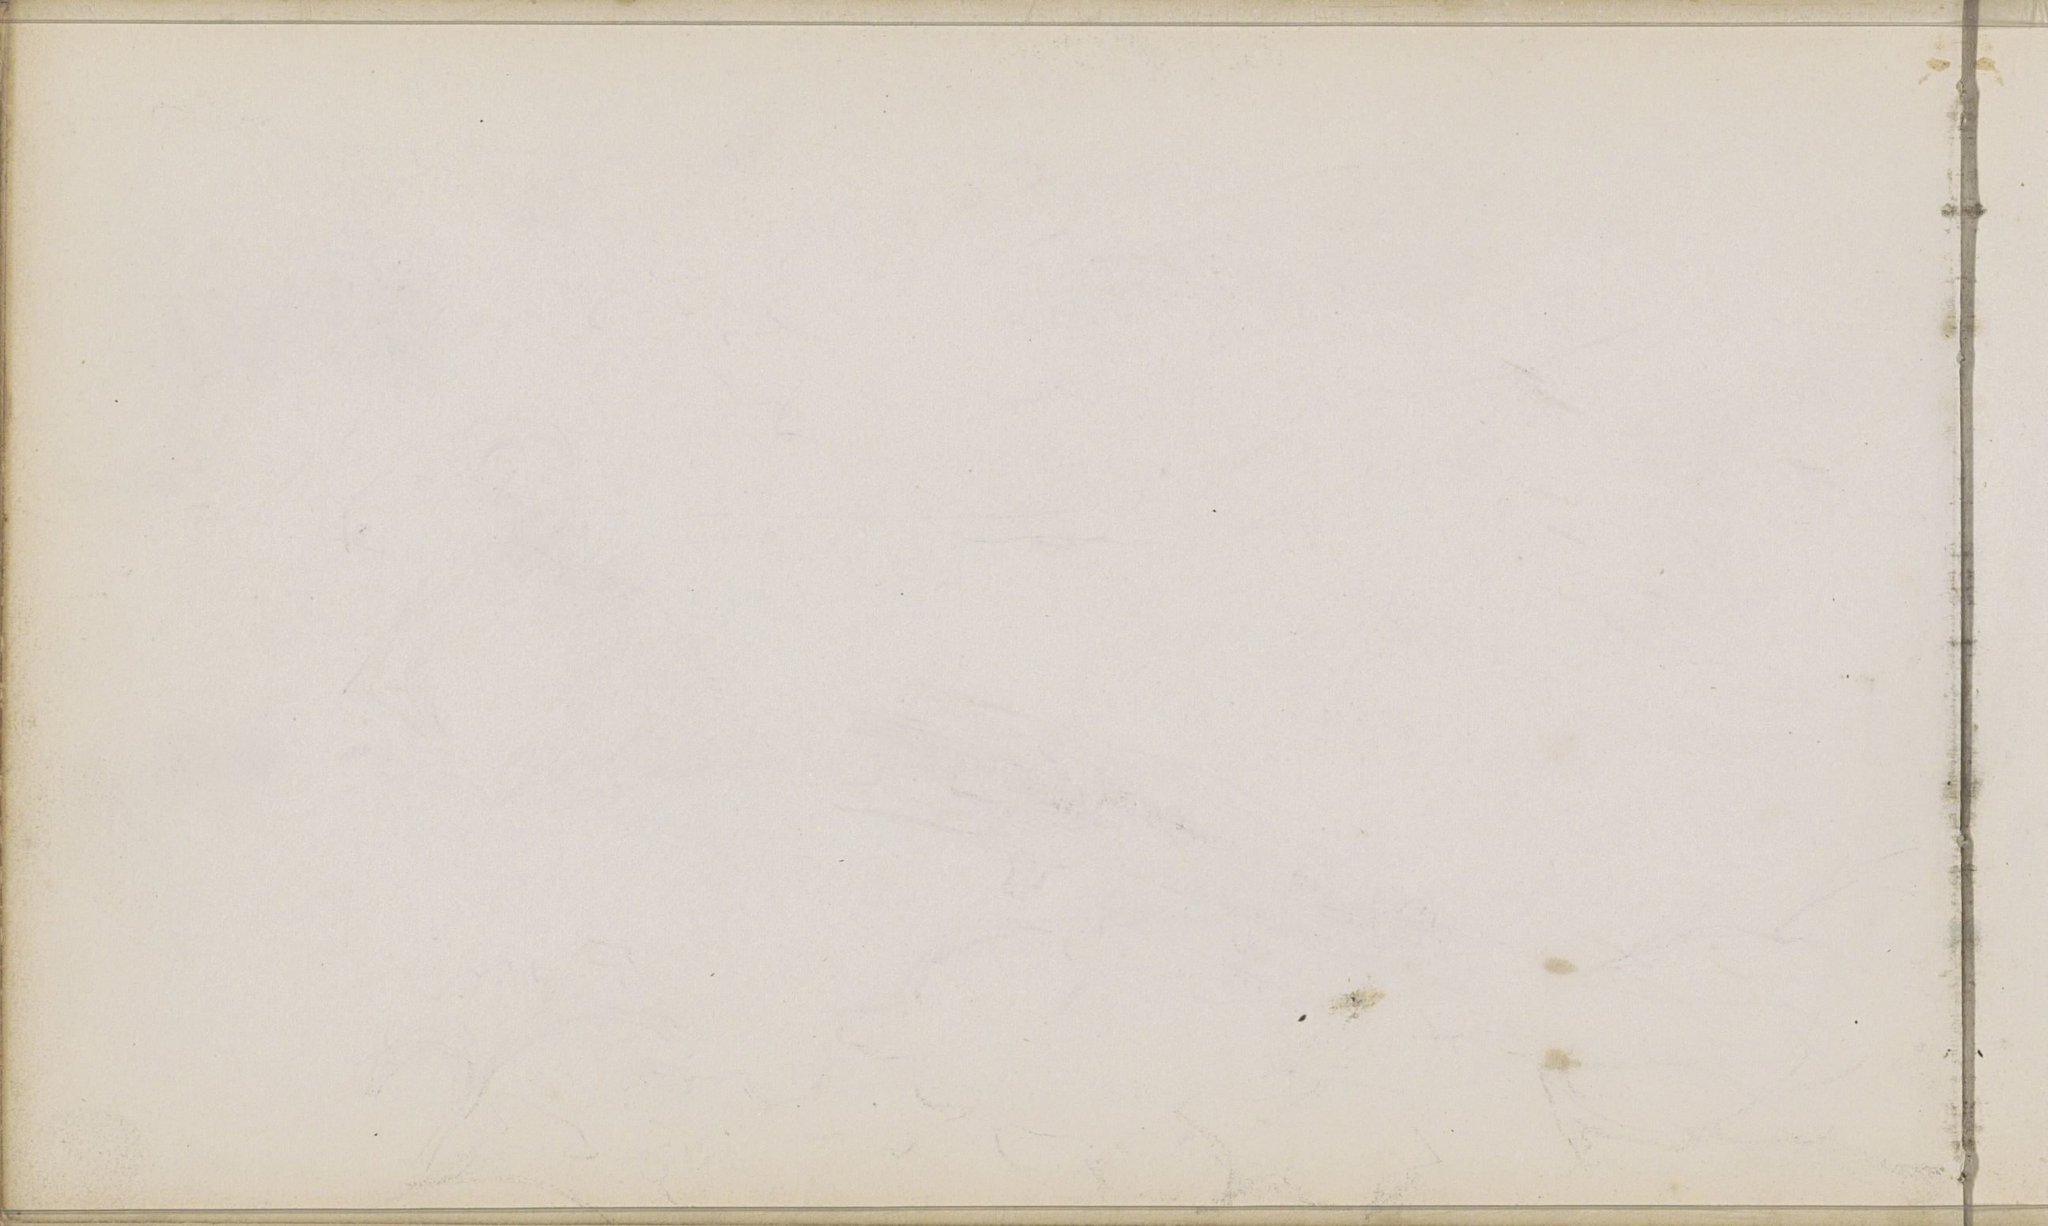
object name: sketchbook leaf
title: Landschap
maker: willem cornelis rip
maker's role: draughtsman, painter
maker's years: 1856-1922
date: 1874-1875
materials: paper, pencil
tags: landscapes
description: Blad 15 verso uit een schetsboek met 46 bladen.